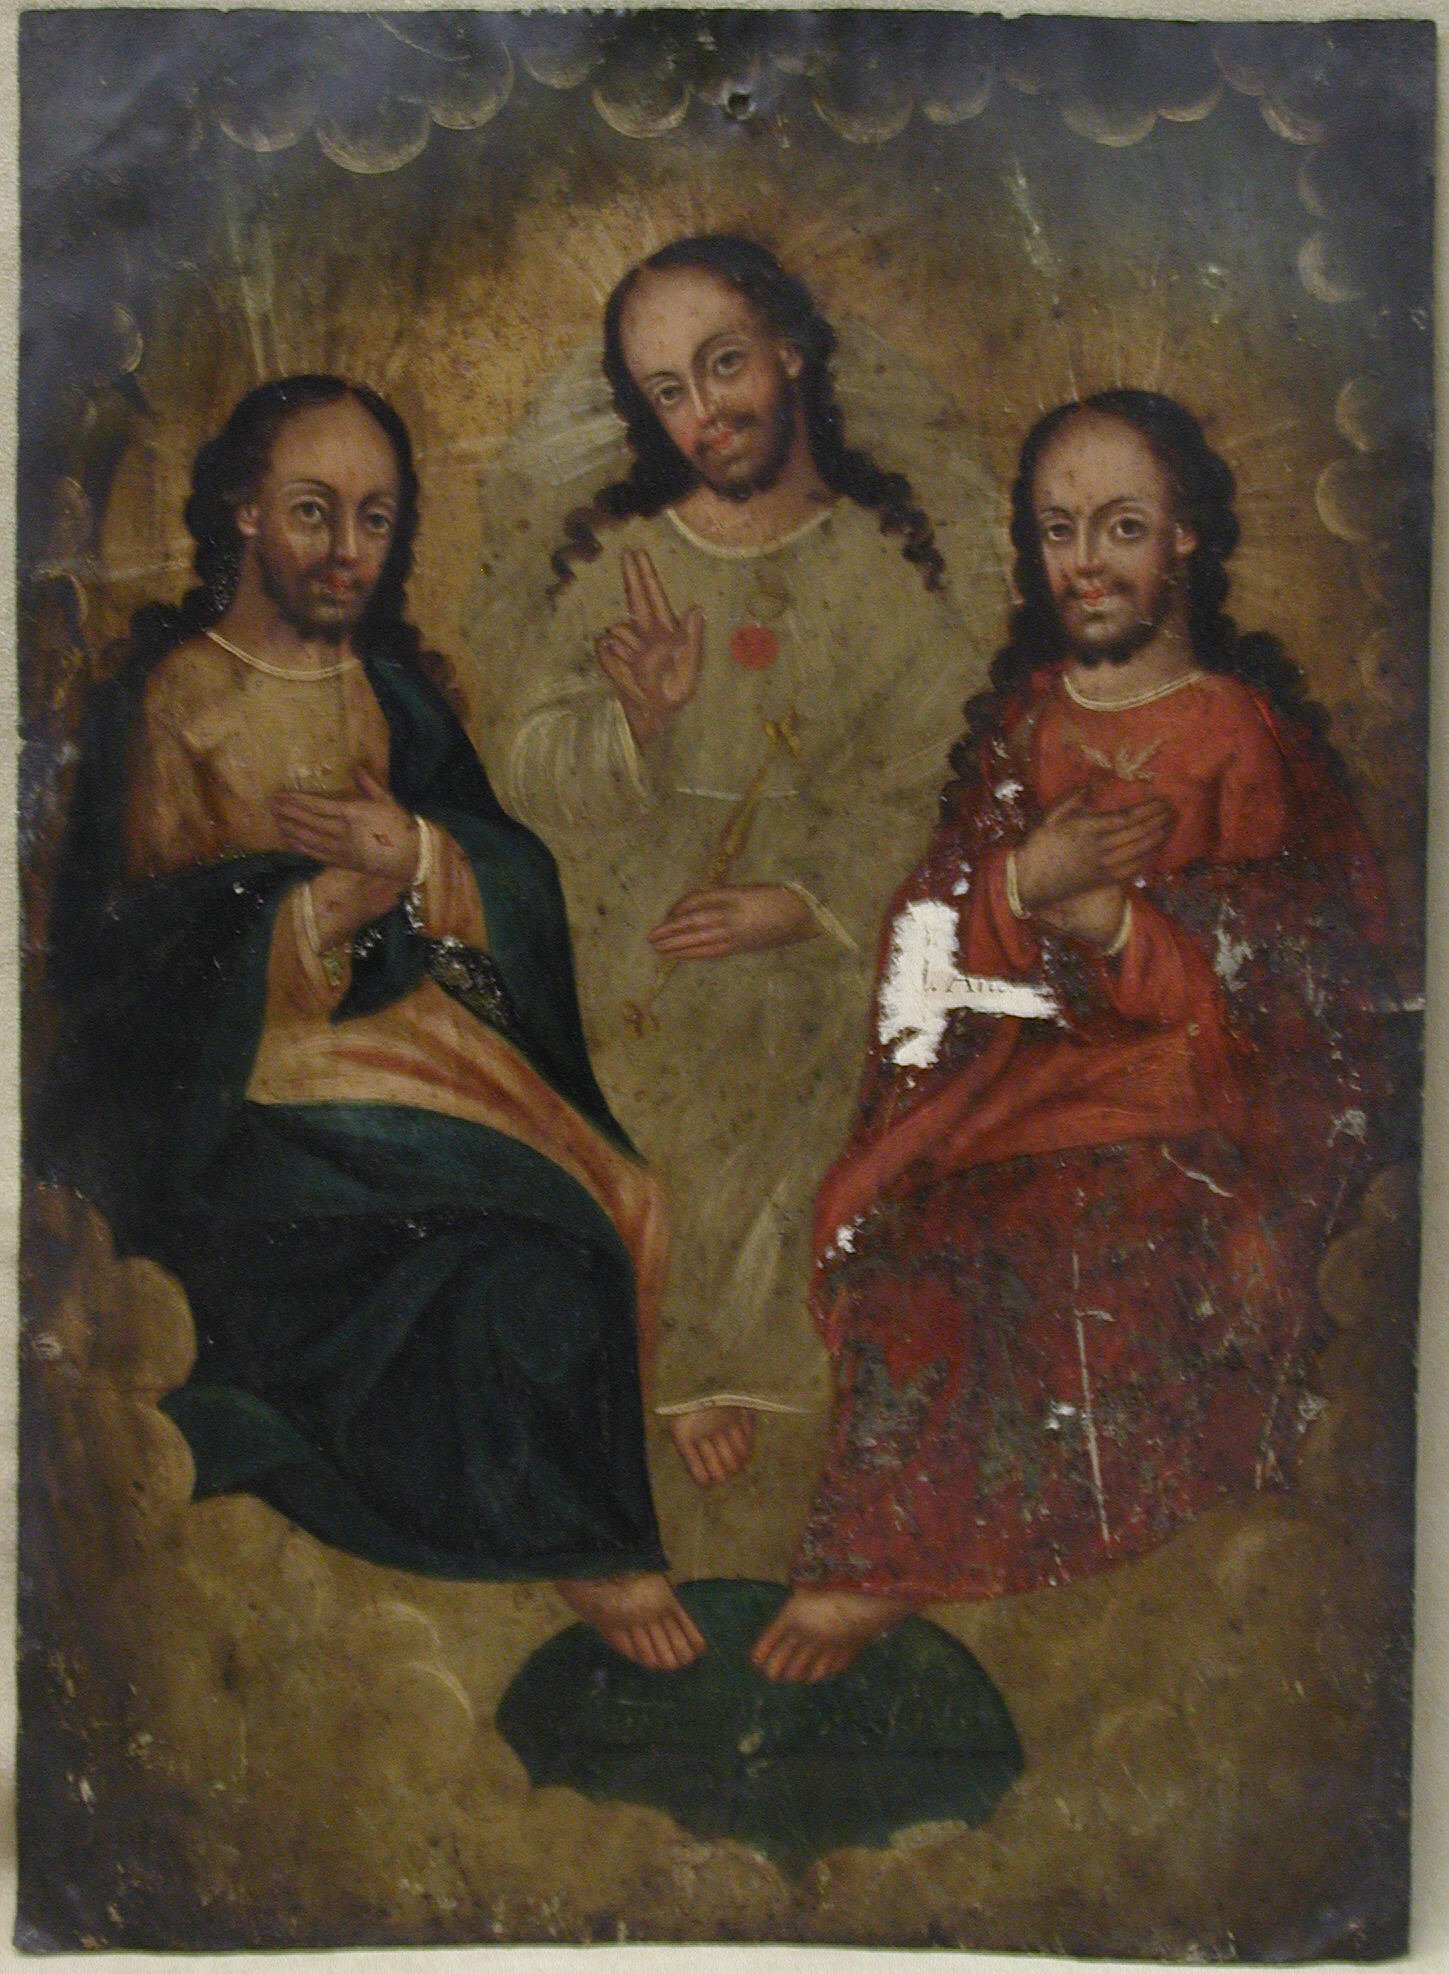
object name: painting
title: The Trinity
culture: spanish colonial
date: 1701-1800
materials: oil, tin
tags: christ,god the father